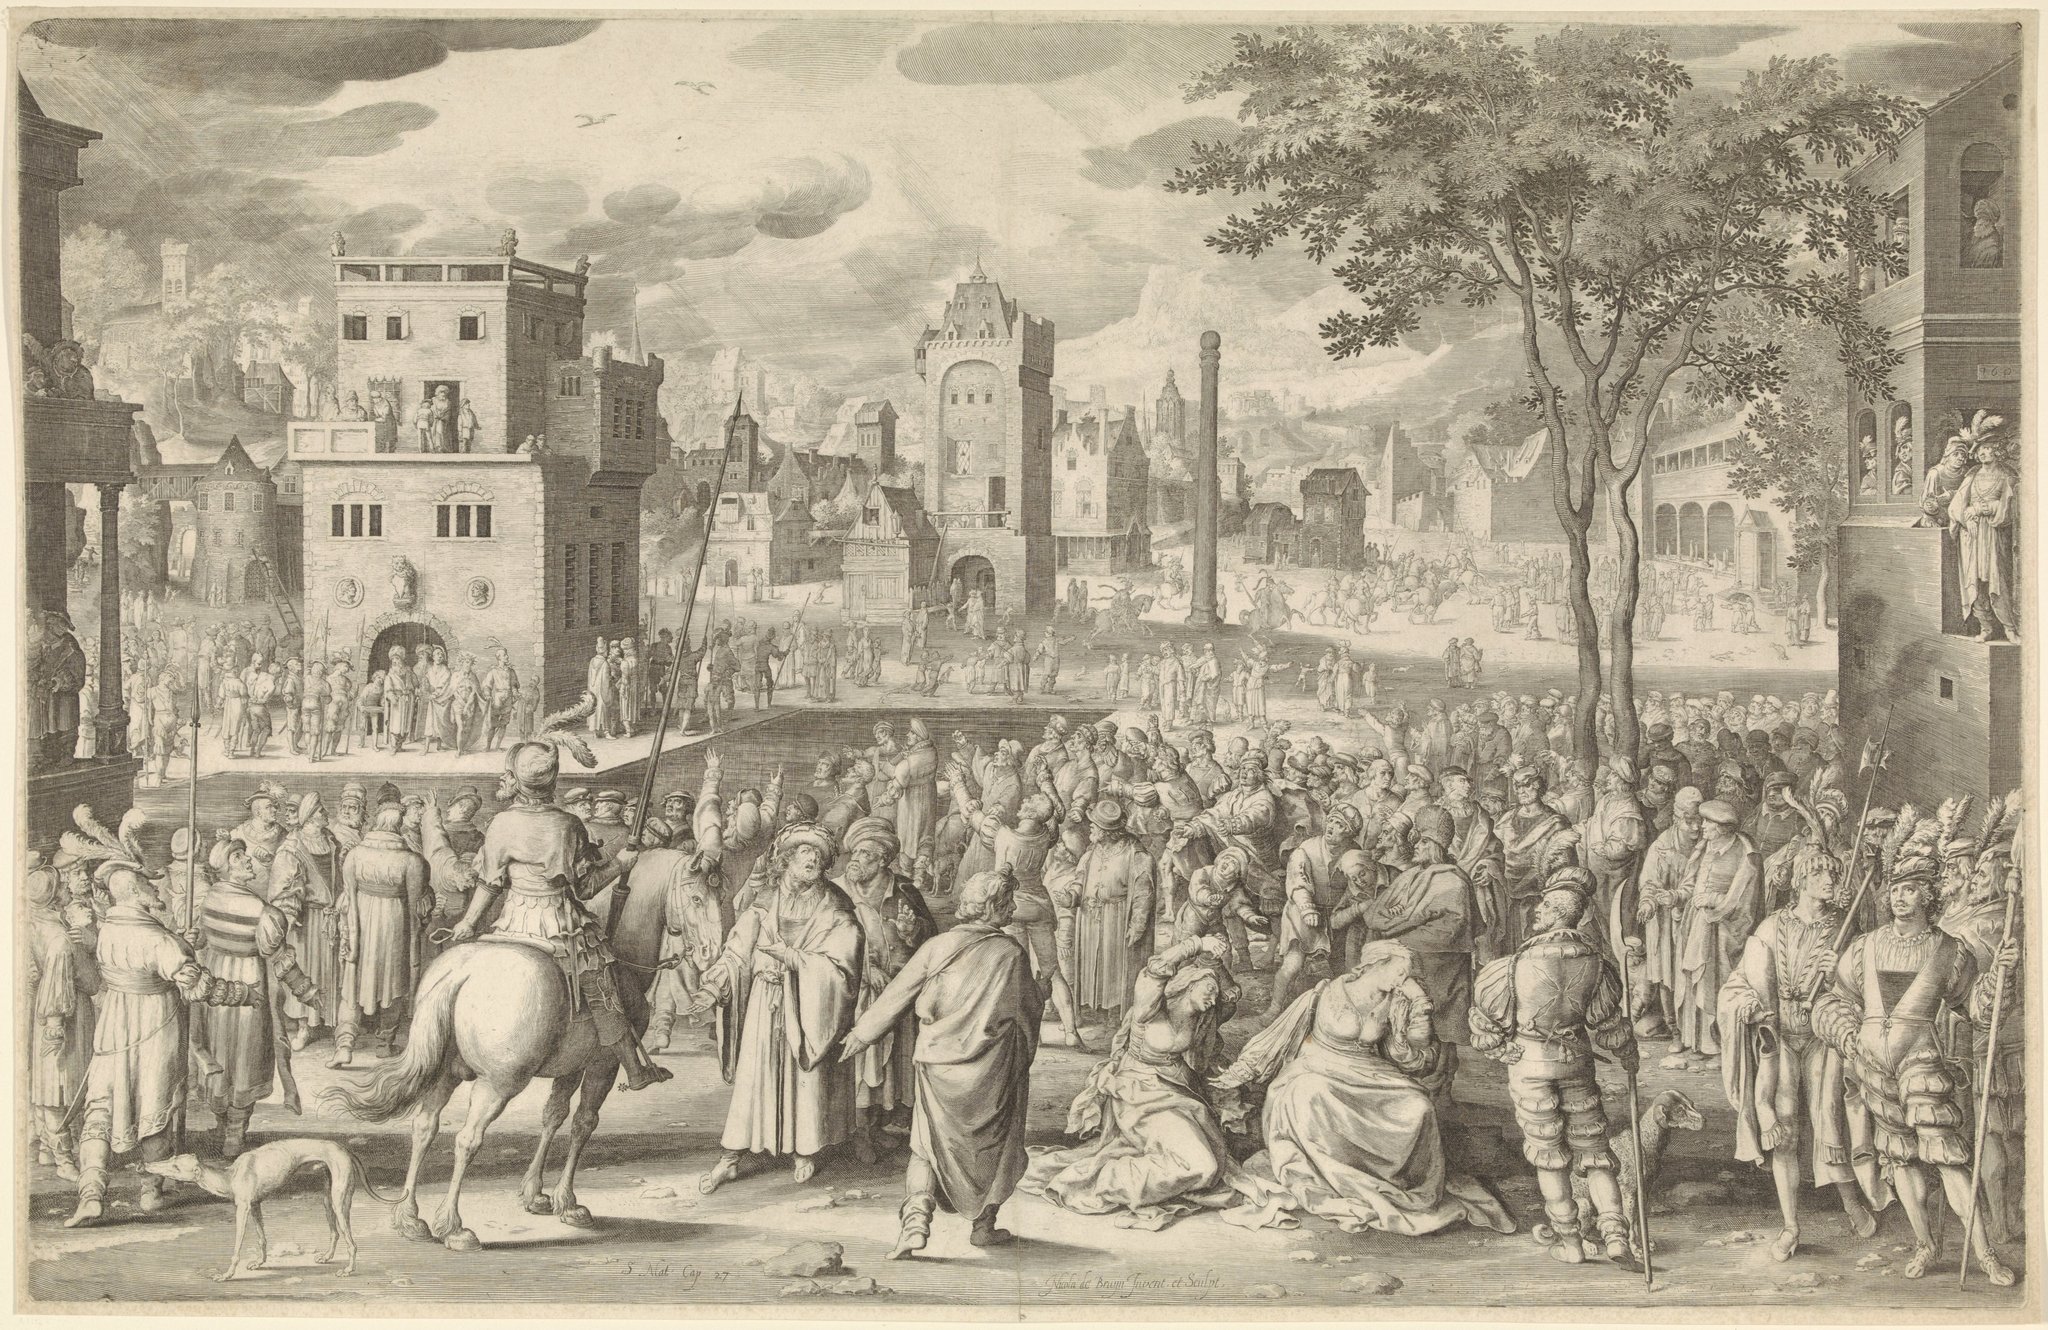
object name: print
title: Ecce Homo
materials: paper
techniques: engraving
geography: amsterdam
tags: pilate showing christ to the people, 'ostentatio christi', 'ecce homo' (john 19:4-6), square, place, circus, etc. (+ city(-scape) with figures, staffage)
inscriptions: collector's mark: Lugt 2228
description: Een stadsplein met op de voorgrond de treurende maagd Maria en Maria Magdalena. Op de achtergrond links toont Pontius Pilatus de gegeselde Christus aan het Joodse volk. Het volk scheeuwt en tiert.